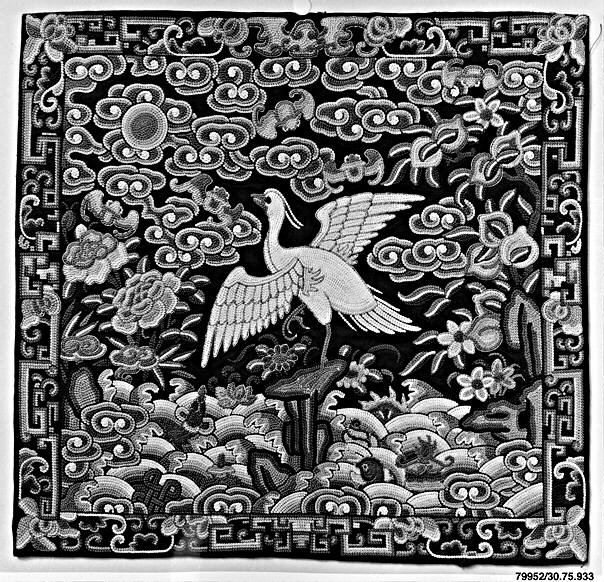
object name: rank badge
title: Rank Badge with Egret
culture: chinese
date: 1767-1833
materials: metal thread, silk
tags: birds